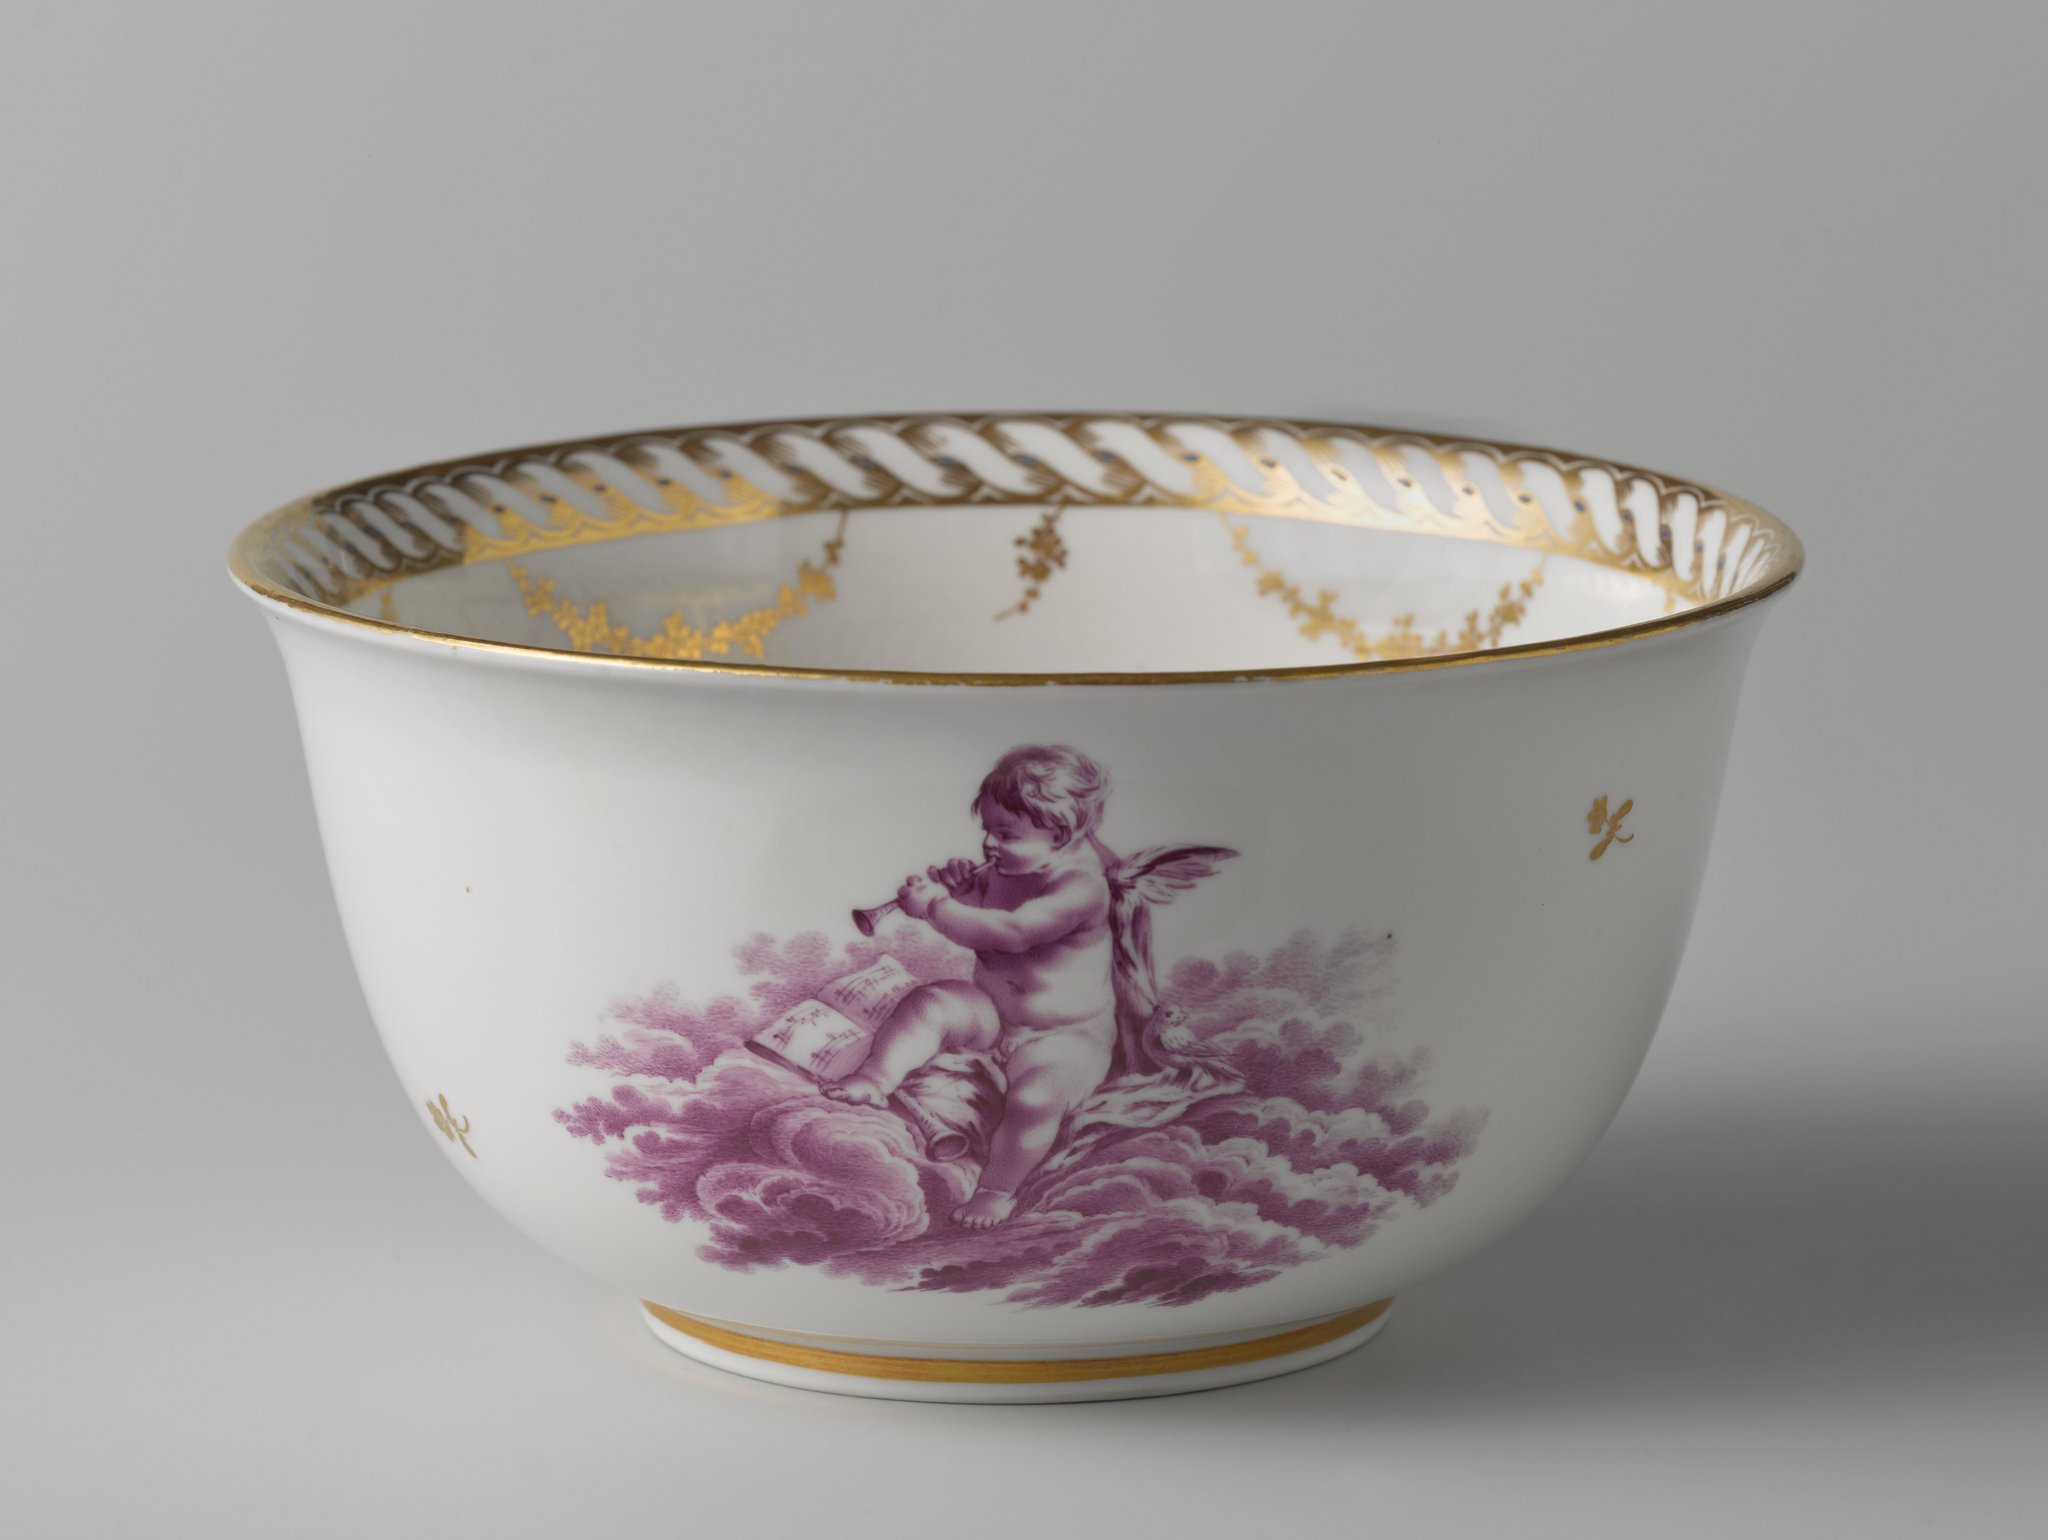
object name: service set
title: Bowl with a putto on clouds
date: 1785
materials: glaze, gold, paint, porcelain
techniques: firing, forming, gilding, turning, vitrification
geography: the hague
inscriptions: mark: ‘ooievaar’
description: Kom (spoelkom) van porselein, beschilderd op het glazuur in roze (camaïeu) en goud. Op de buik een putto op een wolk spelend op een trompet en aan de andere zijde twee vogels op een pijlenkoker op een wolk. Om de voorstellingen strooibloemen in goud. De binnenrand met een gedraaide band, waaraan guirlandes en bloemtakken hangen. Gouden lijn op de voet en gouden rand. Gemerkt op de onderzijde met de ooievaar.